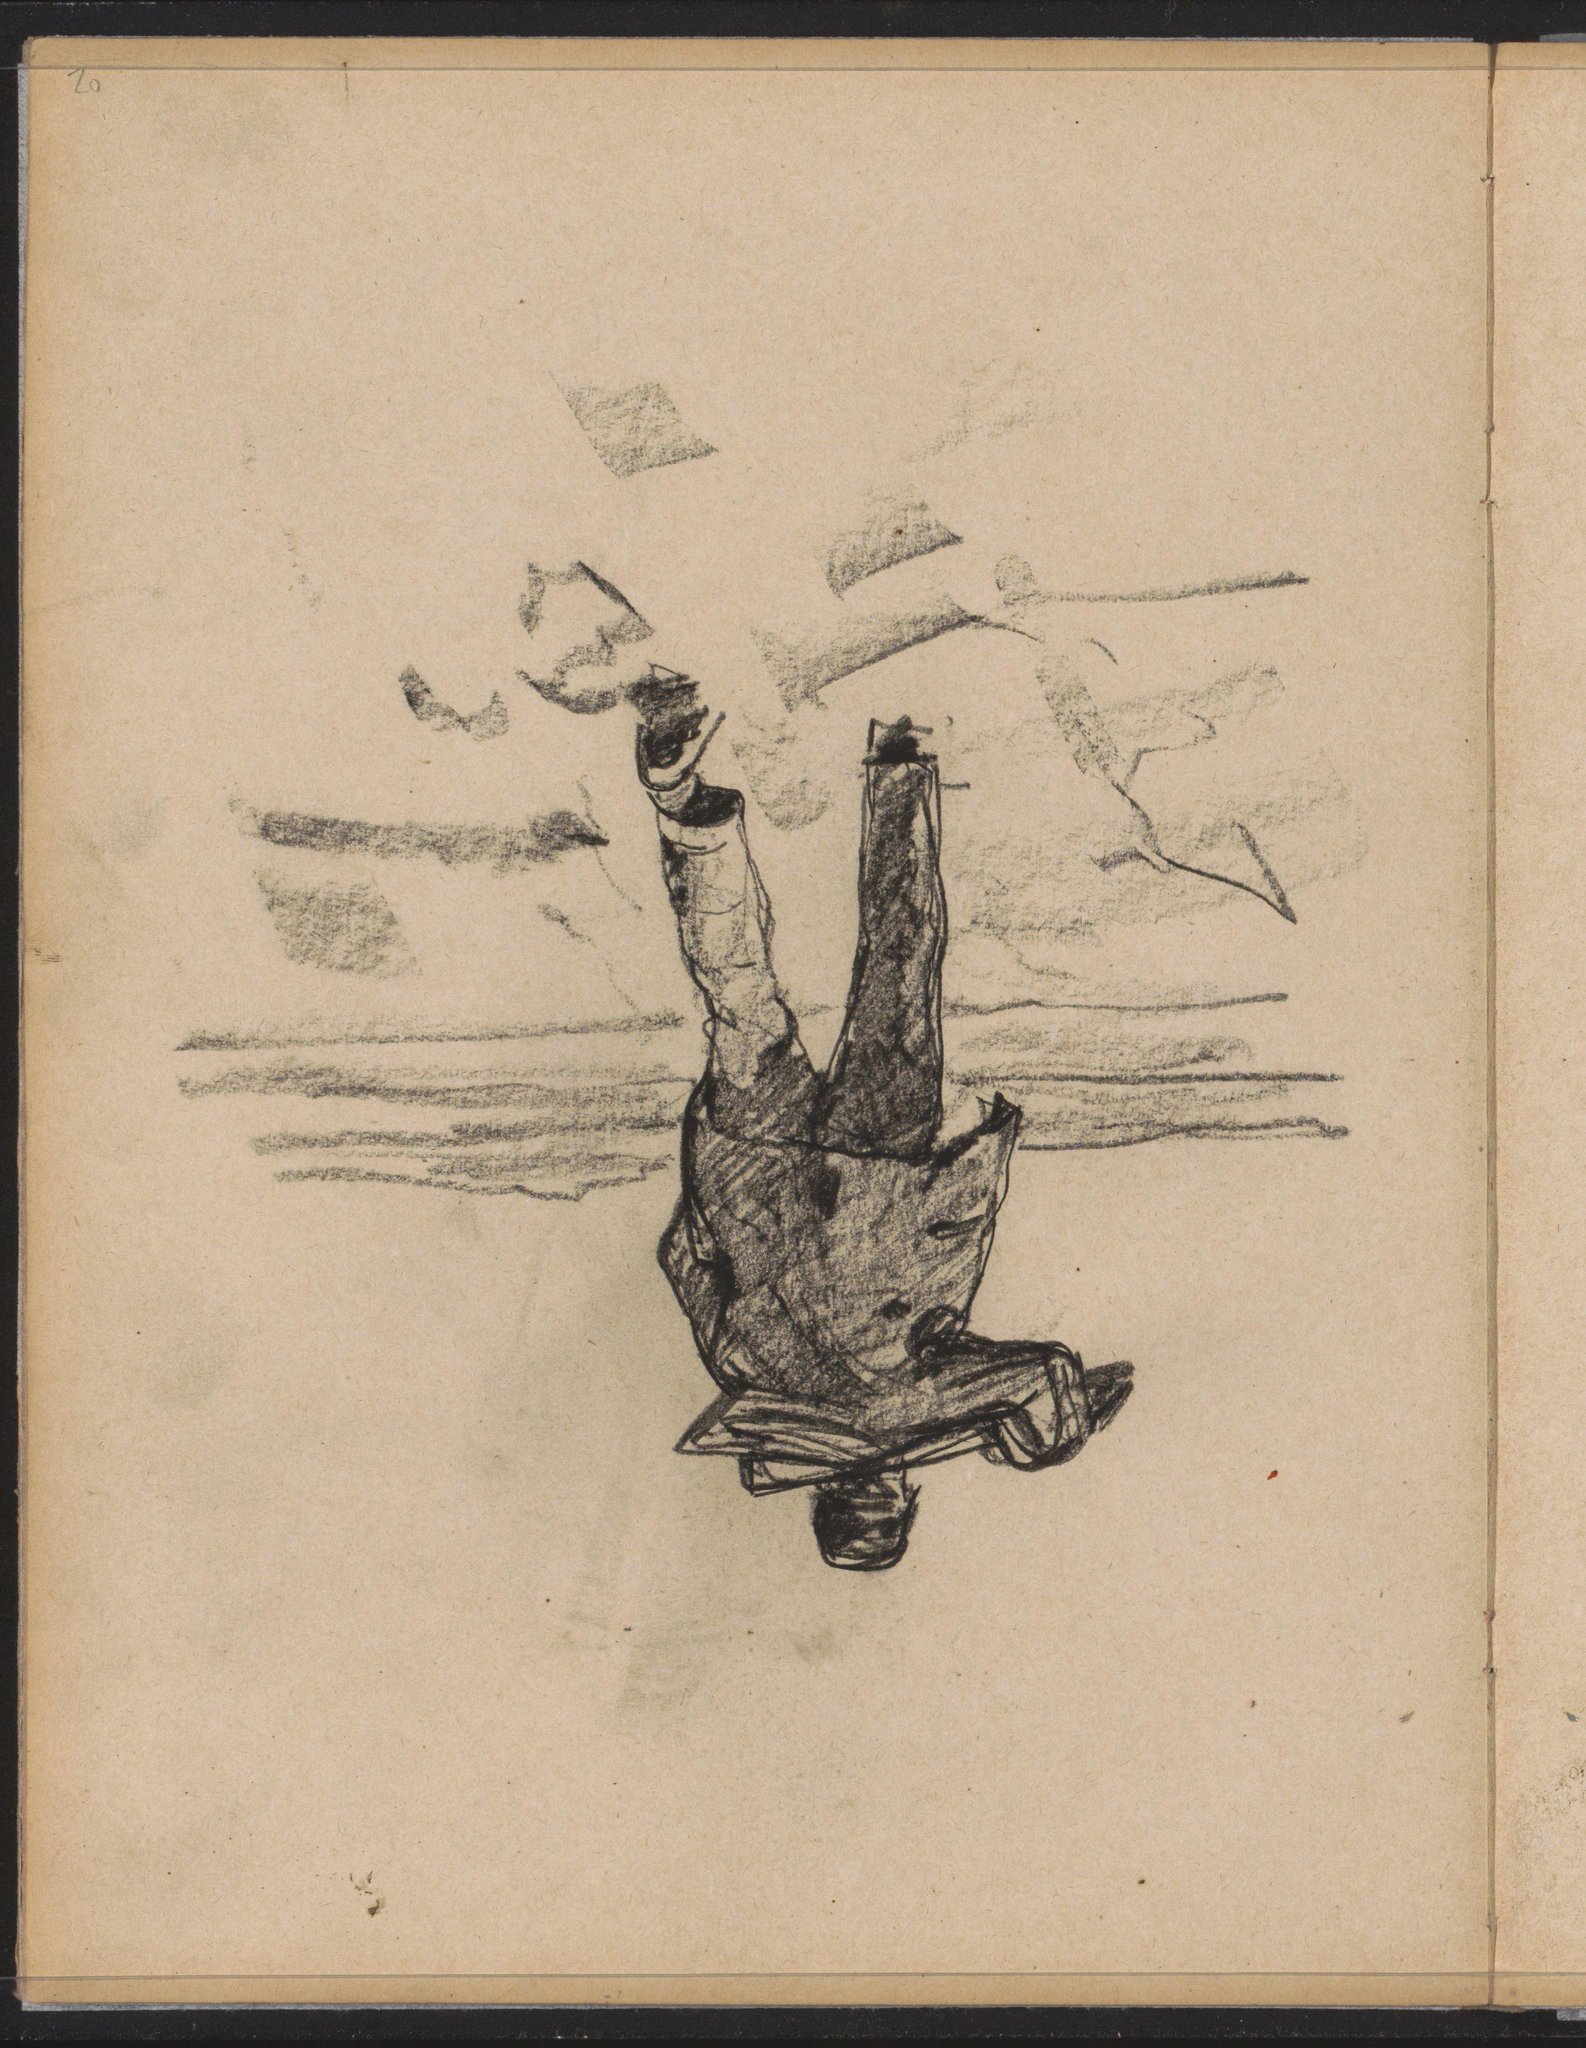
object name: sketchbook leaf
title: Heiwerker met een spade over de schouder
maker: willem witsen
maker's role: draughtsman, painter, print maker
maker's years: 1860-1923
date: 1884-1887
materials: chalk, paper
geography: ewijkshoeve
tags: building-site (+ men (labourers)), walking (+ back view), agricultural implements: spade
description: Voorstudie voor de ets 'Heiwerkers', ca. 1886.